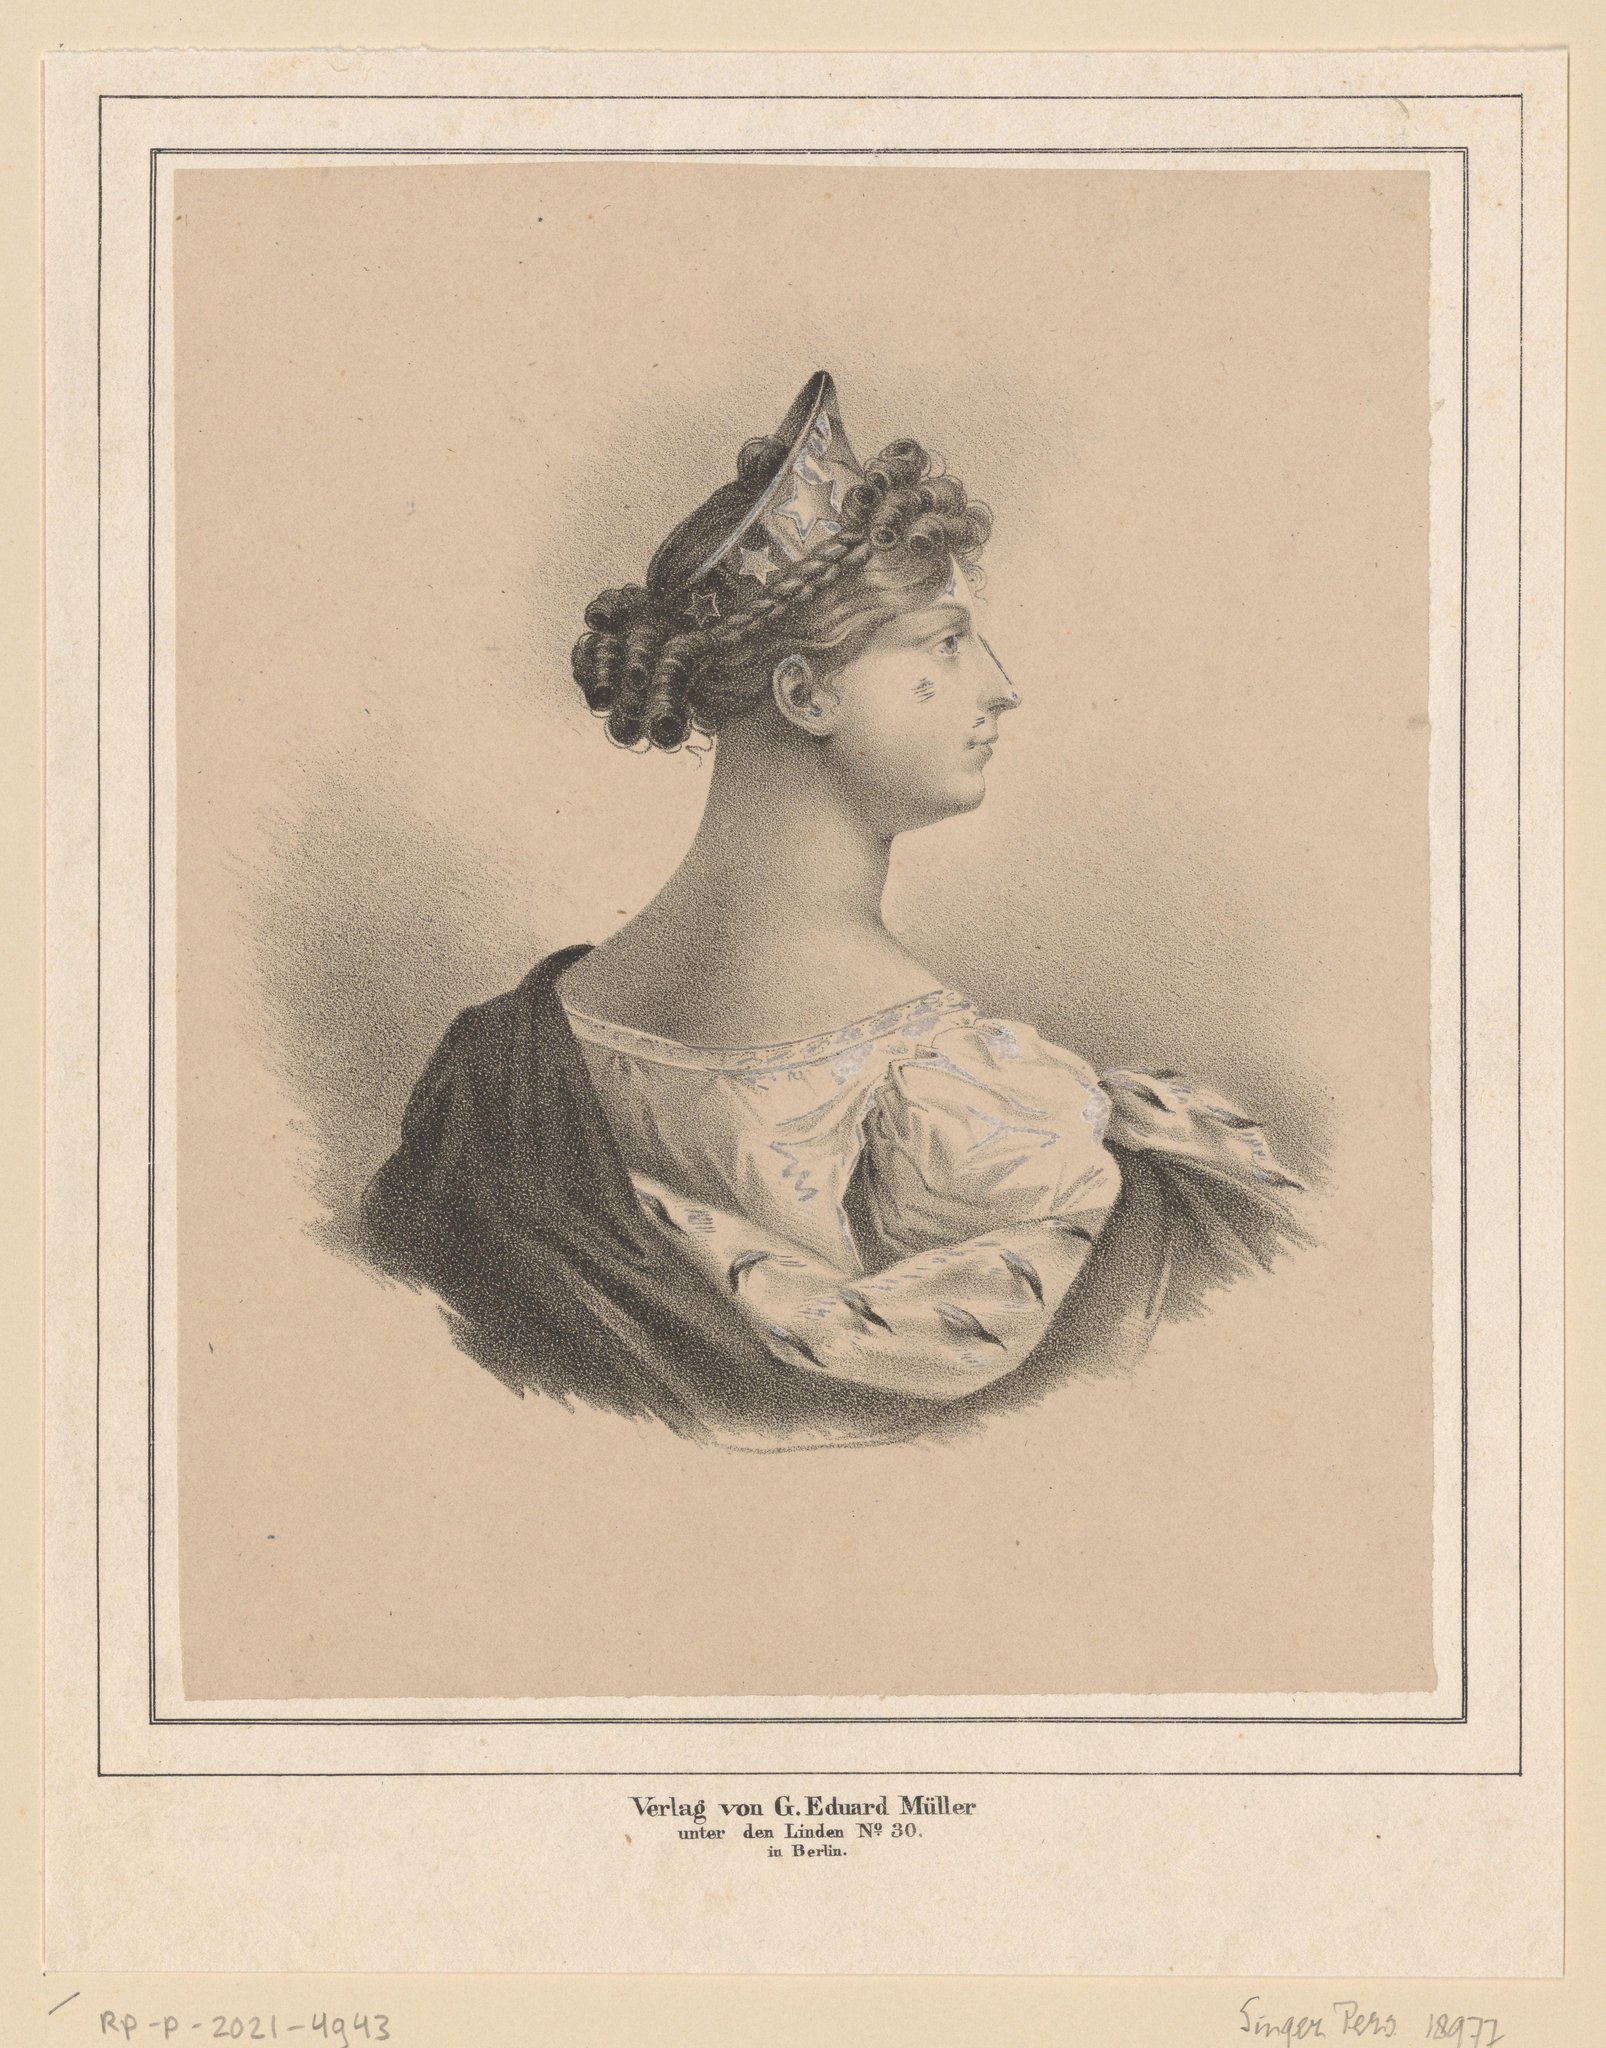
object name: print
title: Portret van Louise van Mecklenburg-Strelitz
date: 1830-1899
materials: paint, paper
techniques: brush, lithograph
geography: berlin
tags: crown (symbol of sovereignty), historical persons - bb - woman, queen